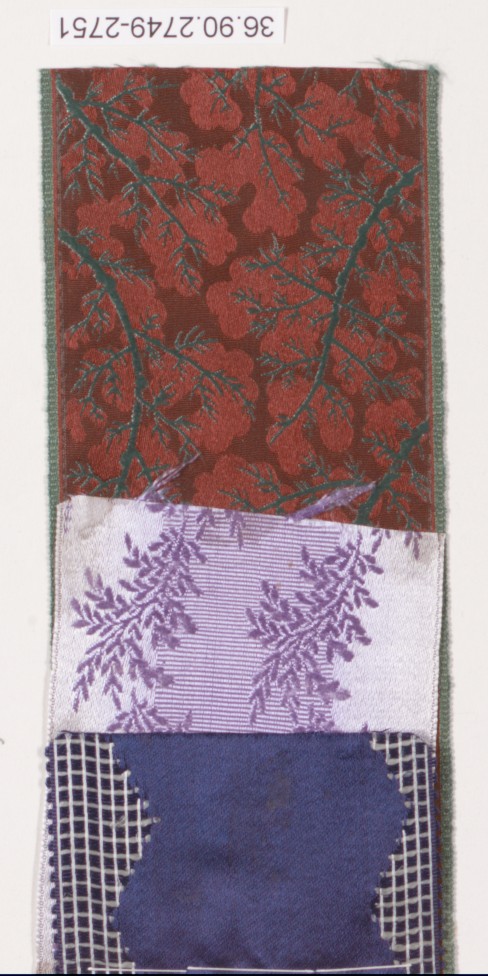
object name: ribbon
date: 1801-1900